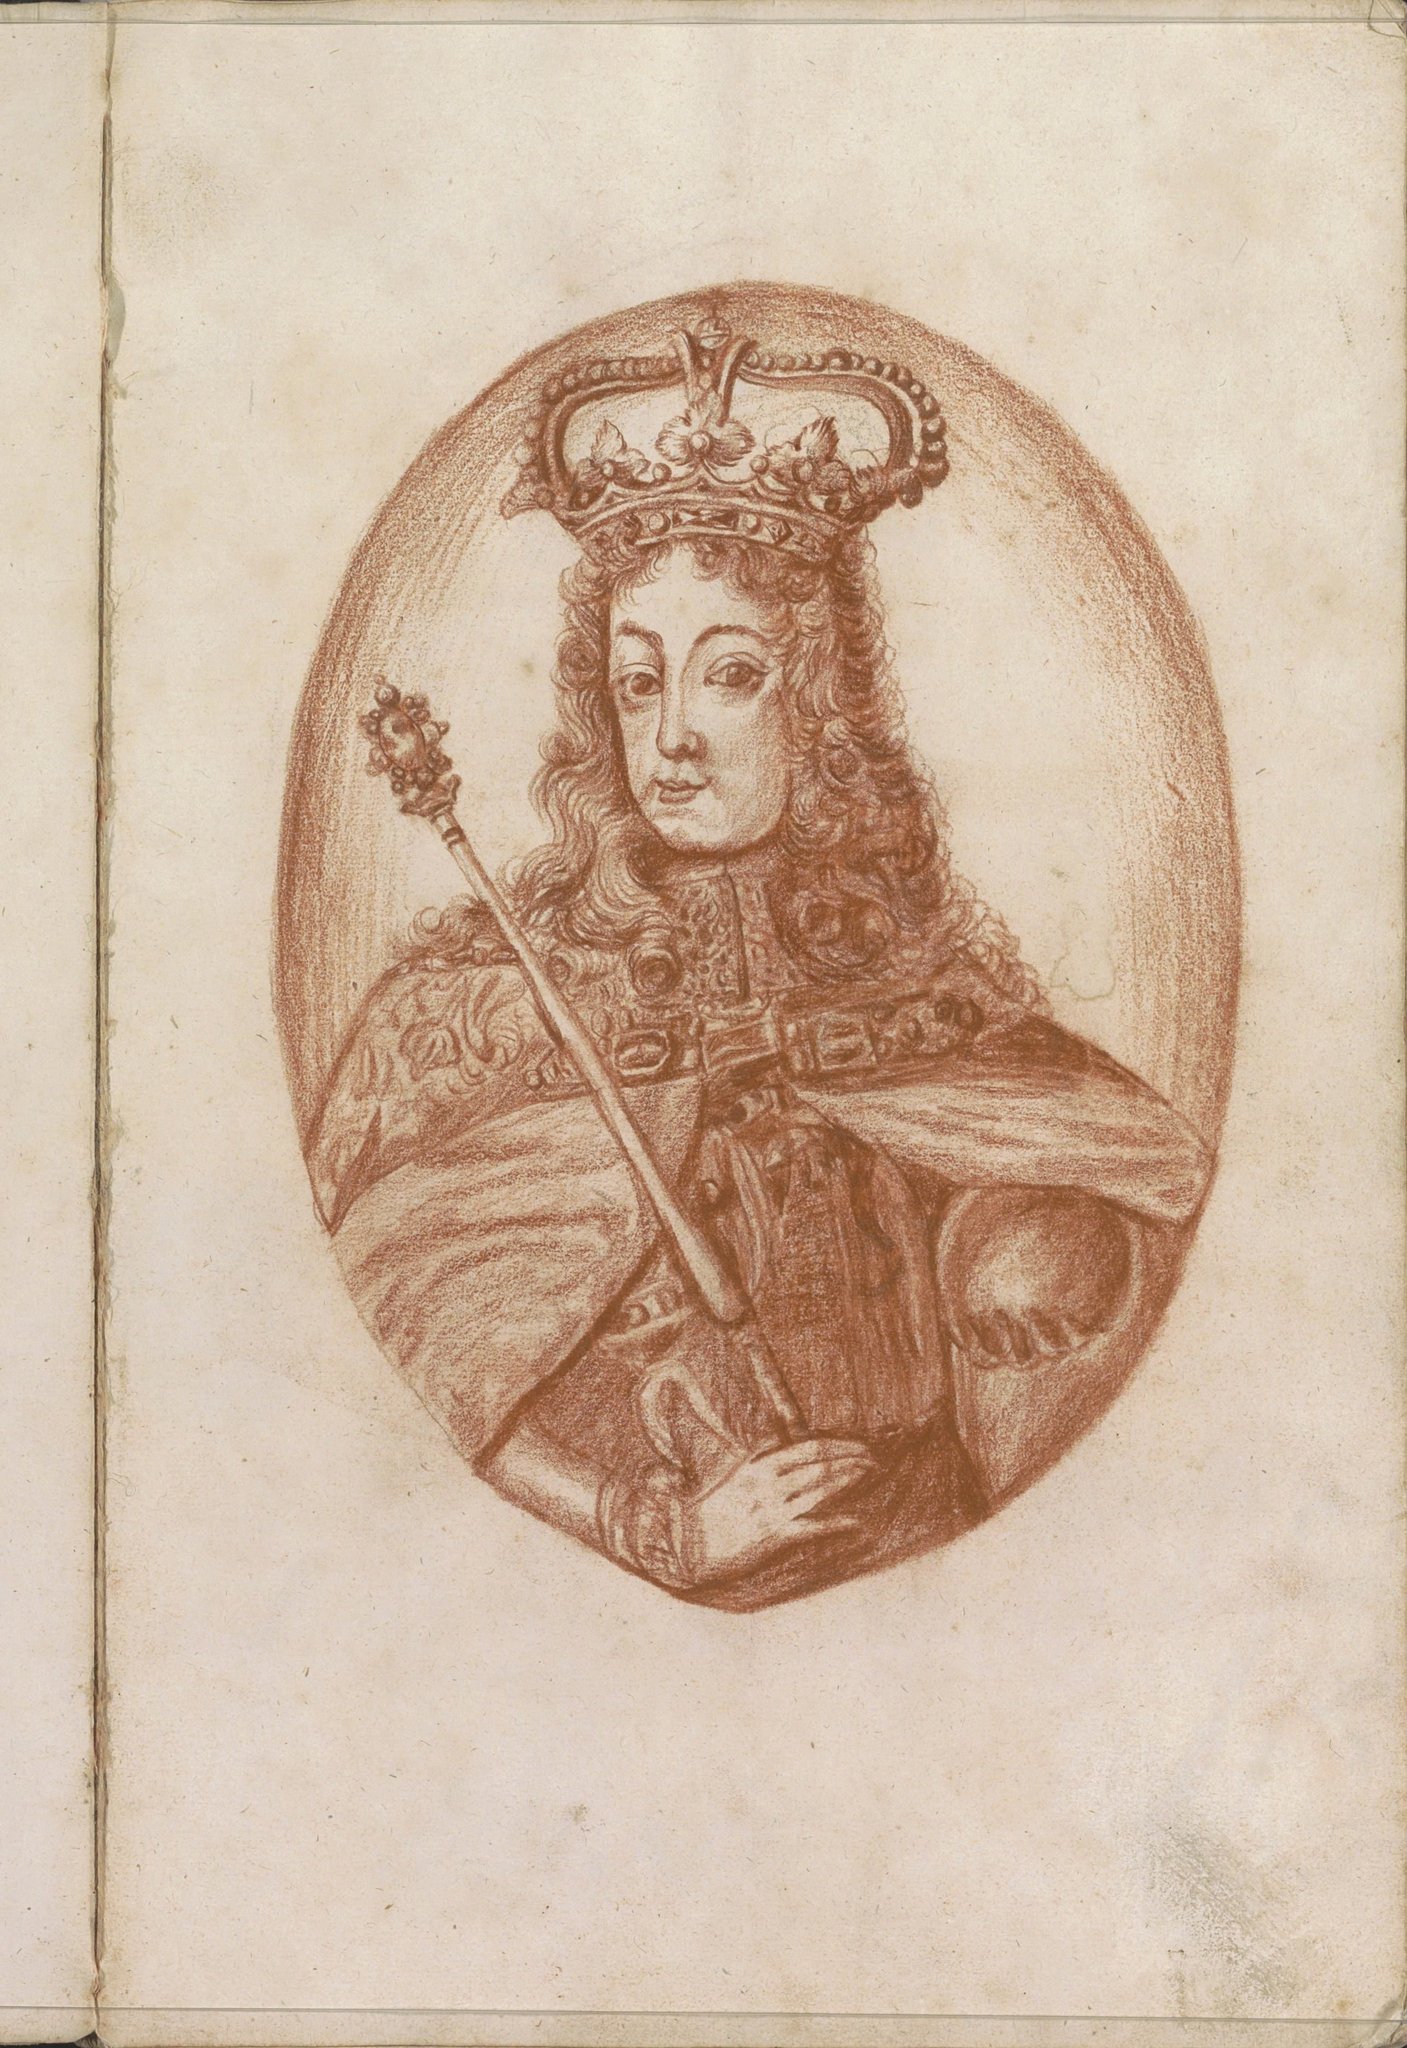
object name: sketchbook leaf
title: Portret van Willem III van Oranje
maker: hendrick van beaumont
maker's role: draughtsman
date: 1696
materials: chalk, paper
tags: the hague, william iii (prince of orange and king of england, scotland, and ireland), ruler, sovereign, insignia and symbols of sovereignty (crown, diadem, sceptre, orb, seal, standard, cloak, pectoral)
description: Willem III draagt een mantel, kroon, scepter en rijksappel. Vermoedelijk getekend naar een prent. Blad 6 recto uit een schetsboek met 91 bladen.